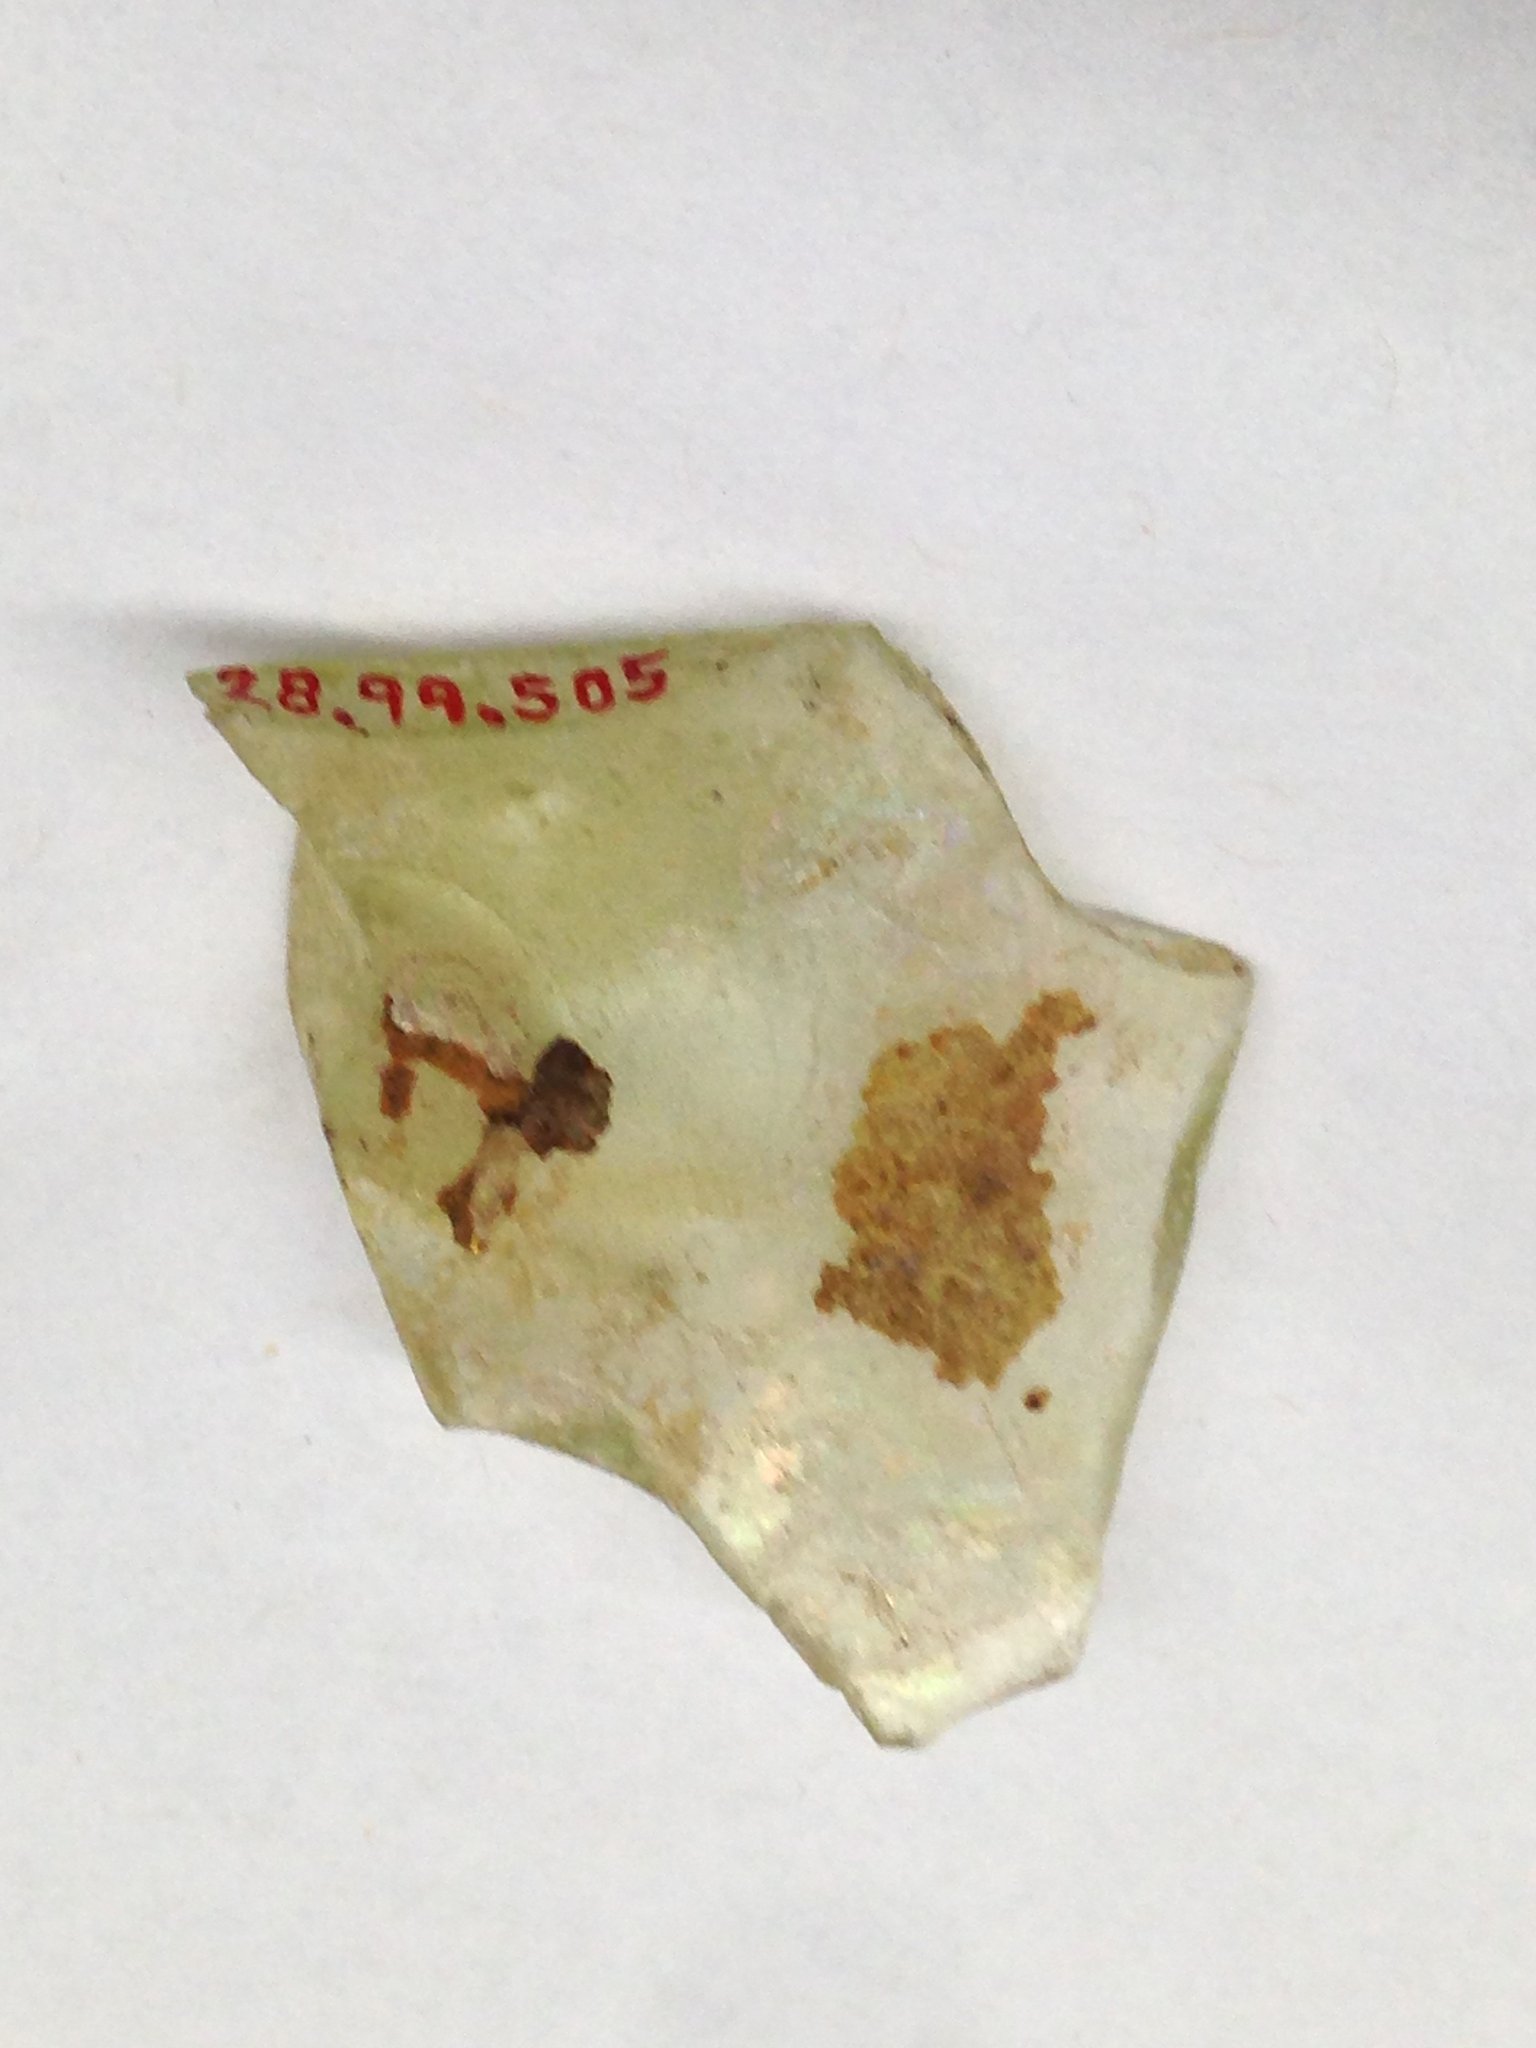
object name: fragment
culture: european or middle eastern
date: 1150-1250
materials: ceramic, glass